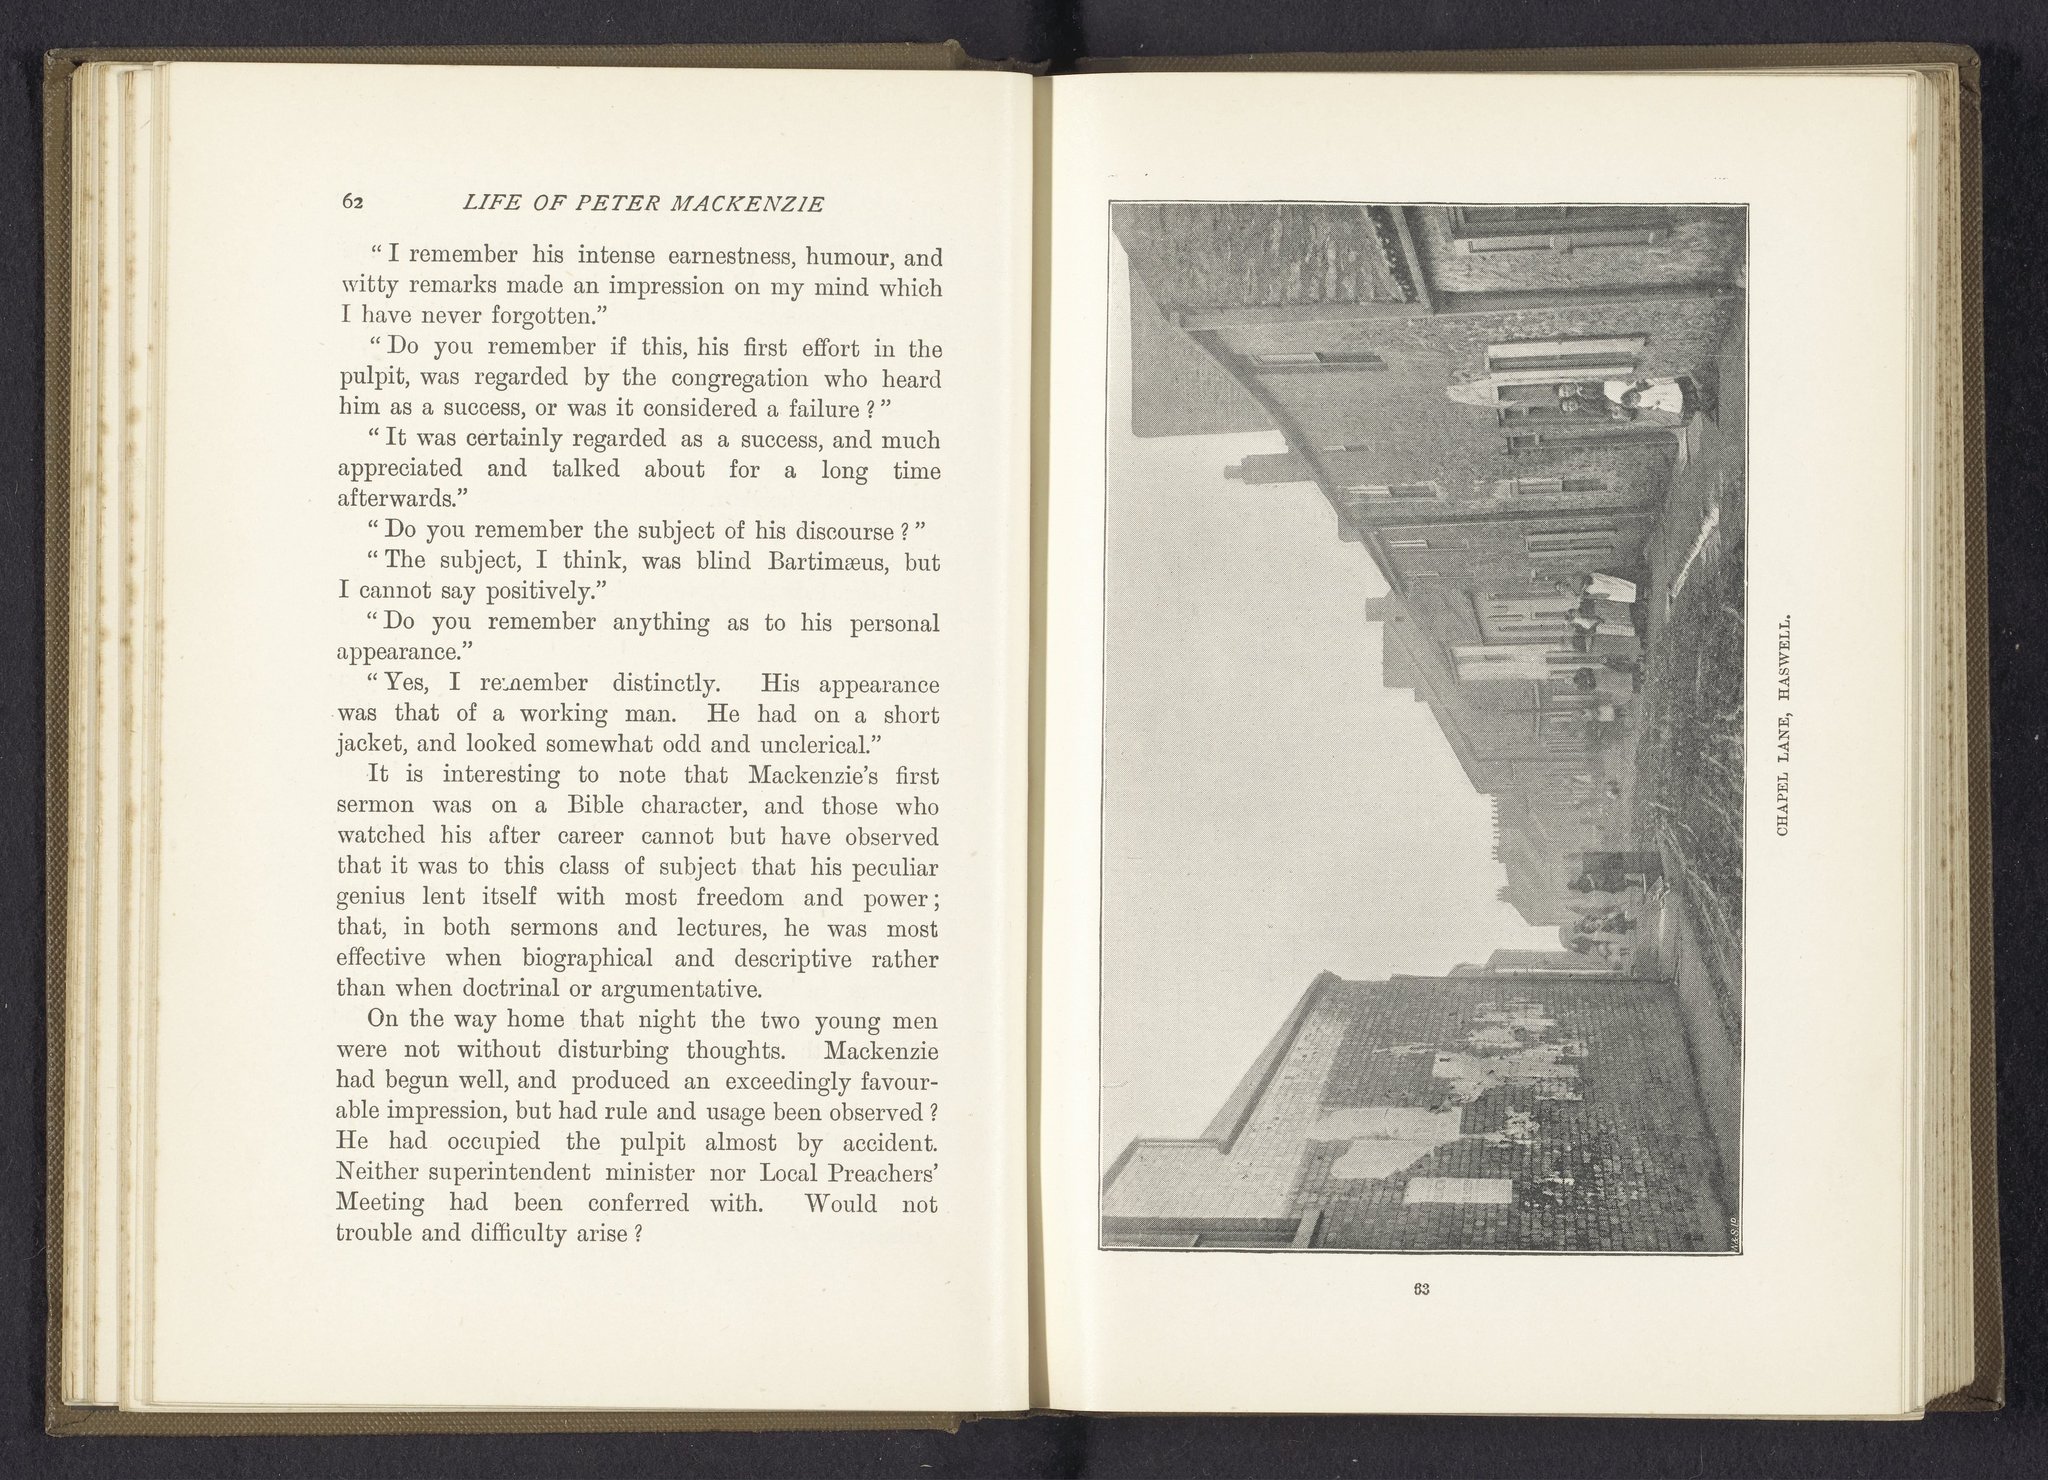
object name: page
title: Chapel Lane, Haswell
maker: Anonymous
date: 1887-1897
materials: paper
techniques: autotype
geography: haswell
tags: housing, façade (of house or building), street